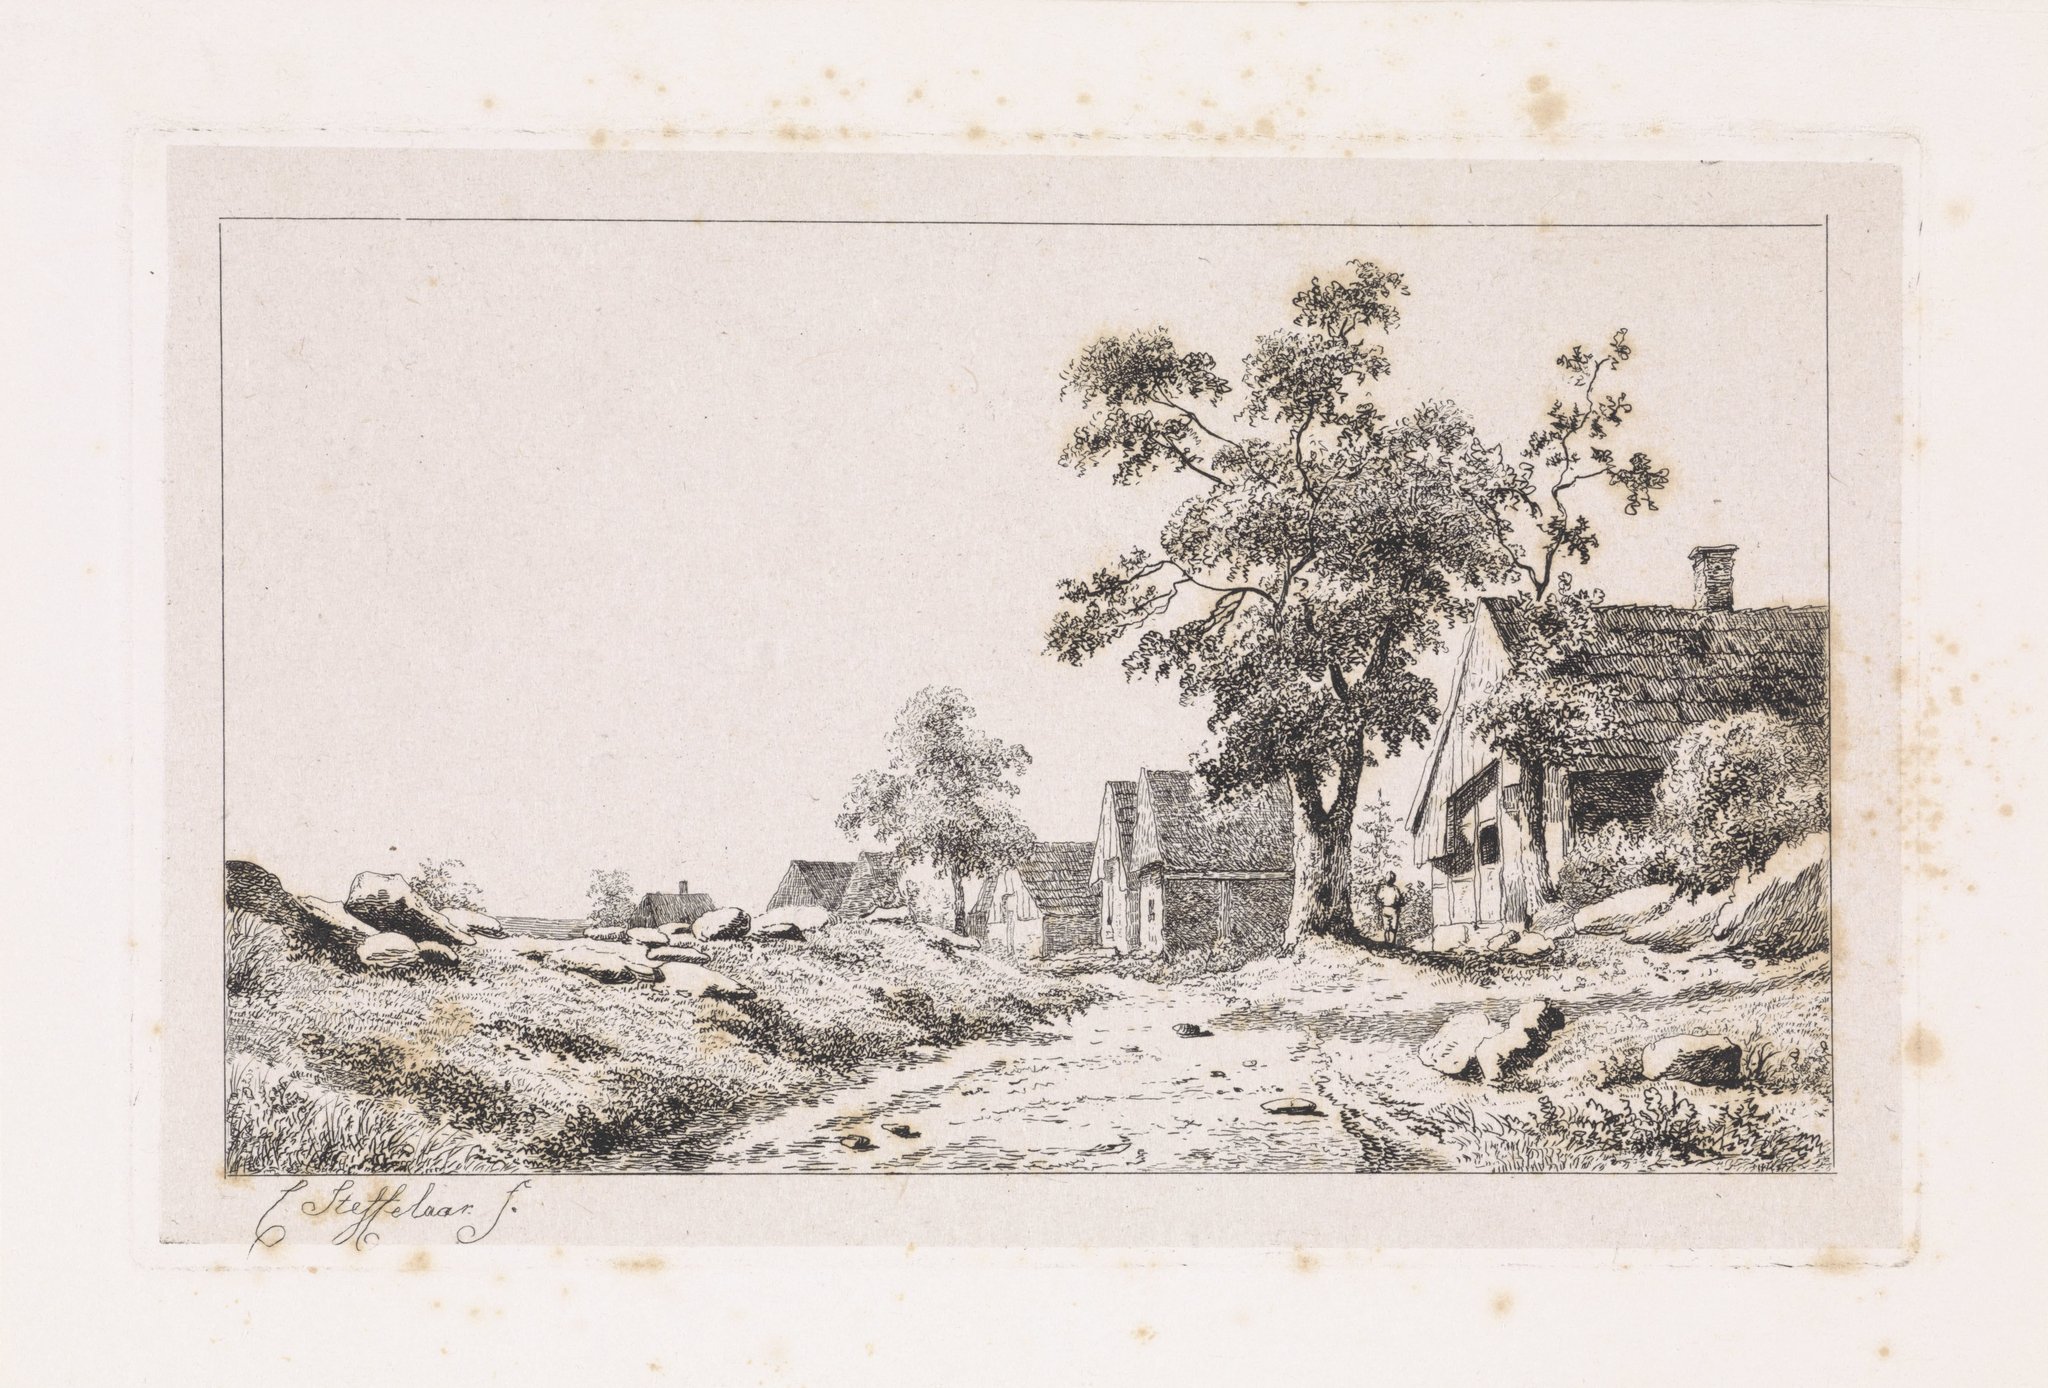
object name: print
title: Derde suite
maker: cornelis steffelaar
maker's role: draughtsman, painter, print maker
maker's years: 1797-1861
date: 1807-1861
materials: paper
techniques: etching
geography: amsterdam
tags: public road in village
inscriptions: collector's mark: Lugt 1485, collector's mark: Lugt 2228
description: Zicht op een weg, die iets omhoog loopt, en waarlangs huizen staan.